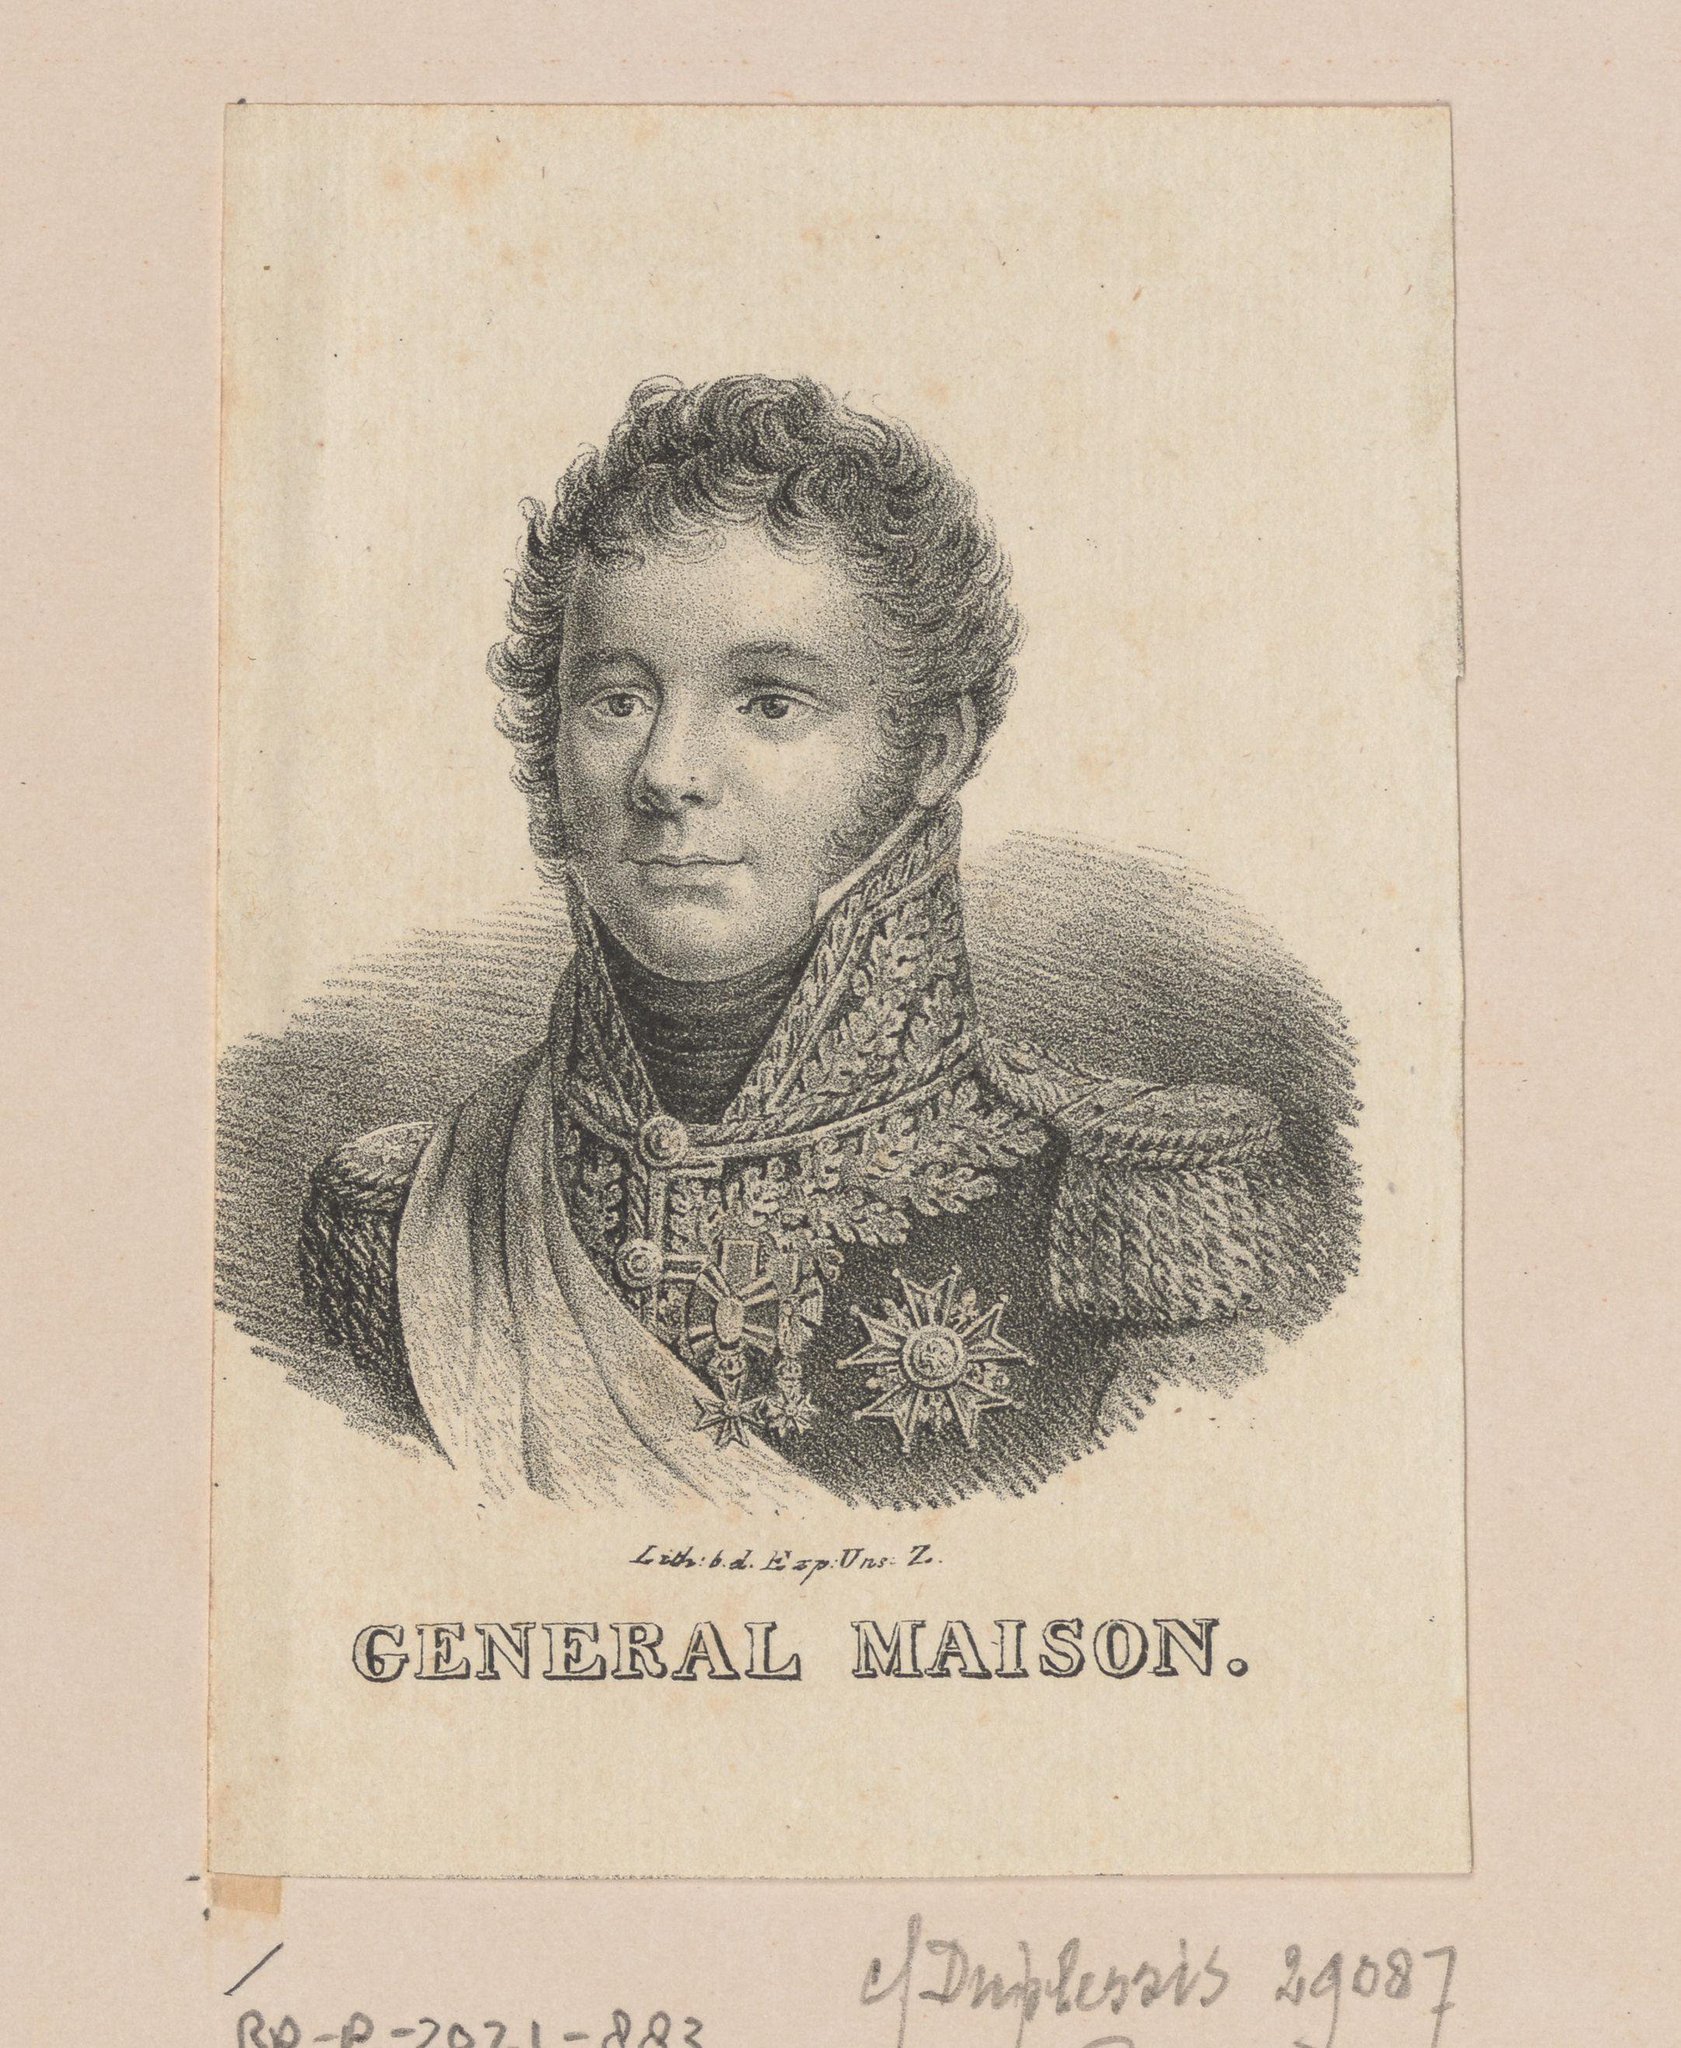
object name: print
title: Portret van Nicolas Joseph Maison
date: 1800-1899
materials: paper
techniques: lithograph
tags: paris, commander-in-chief, general, marshal, historical persons